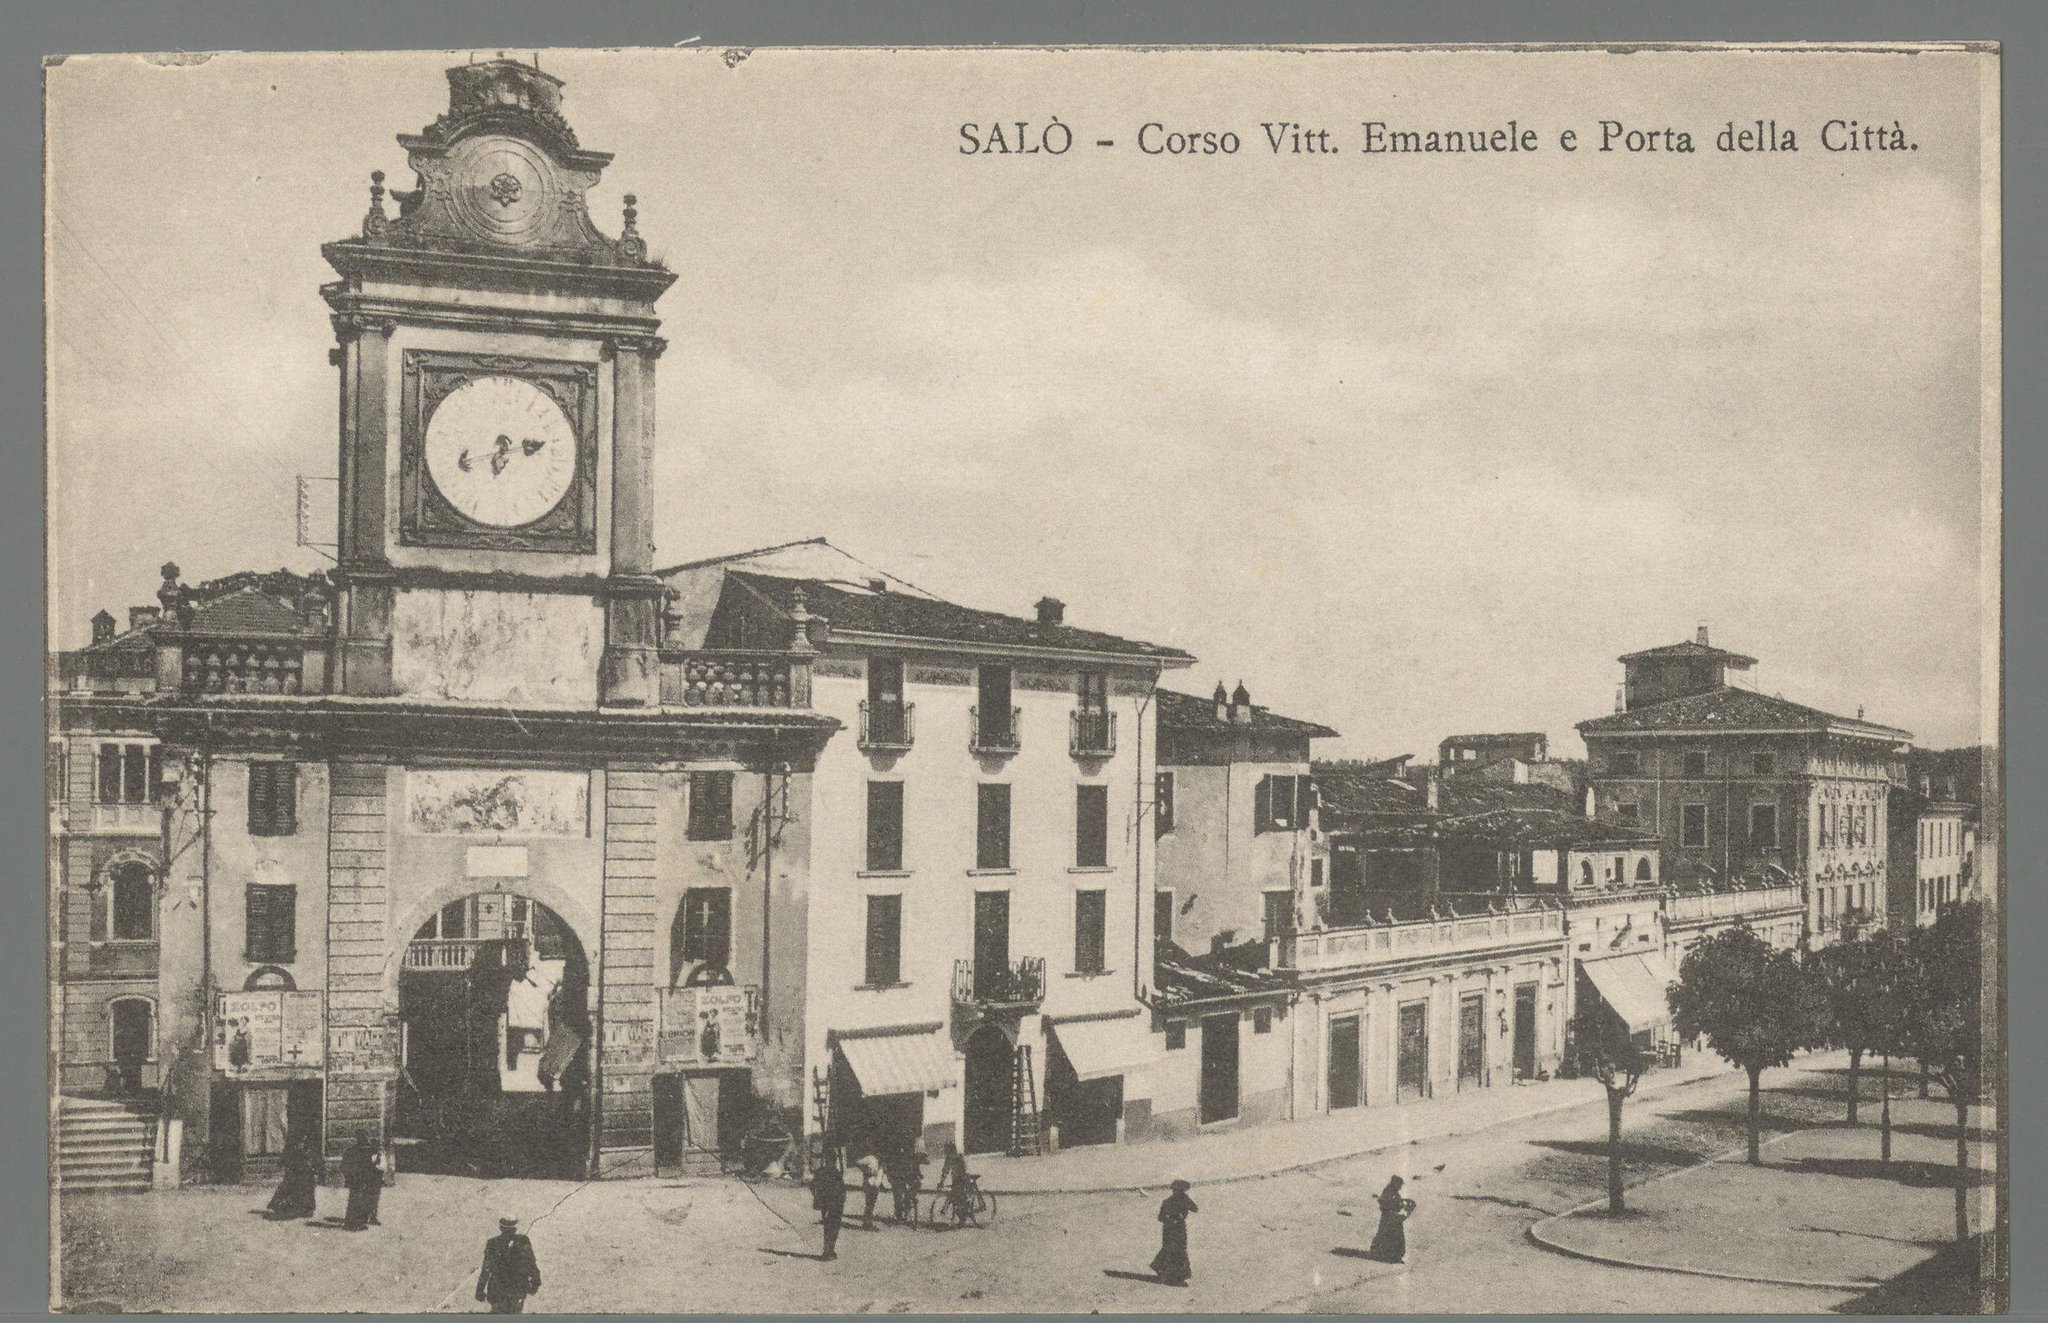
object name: photomechanical print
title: Salò. Corso Vitt. Emanuele e Porta della Città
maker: Anonymous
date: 1906-1930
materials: cardboard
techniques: photograph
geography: salò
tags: city-gate, city-view, and landscape with man-made constructions (+ city(-scape) with figures, staffage)